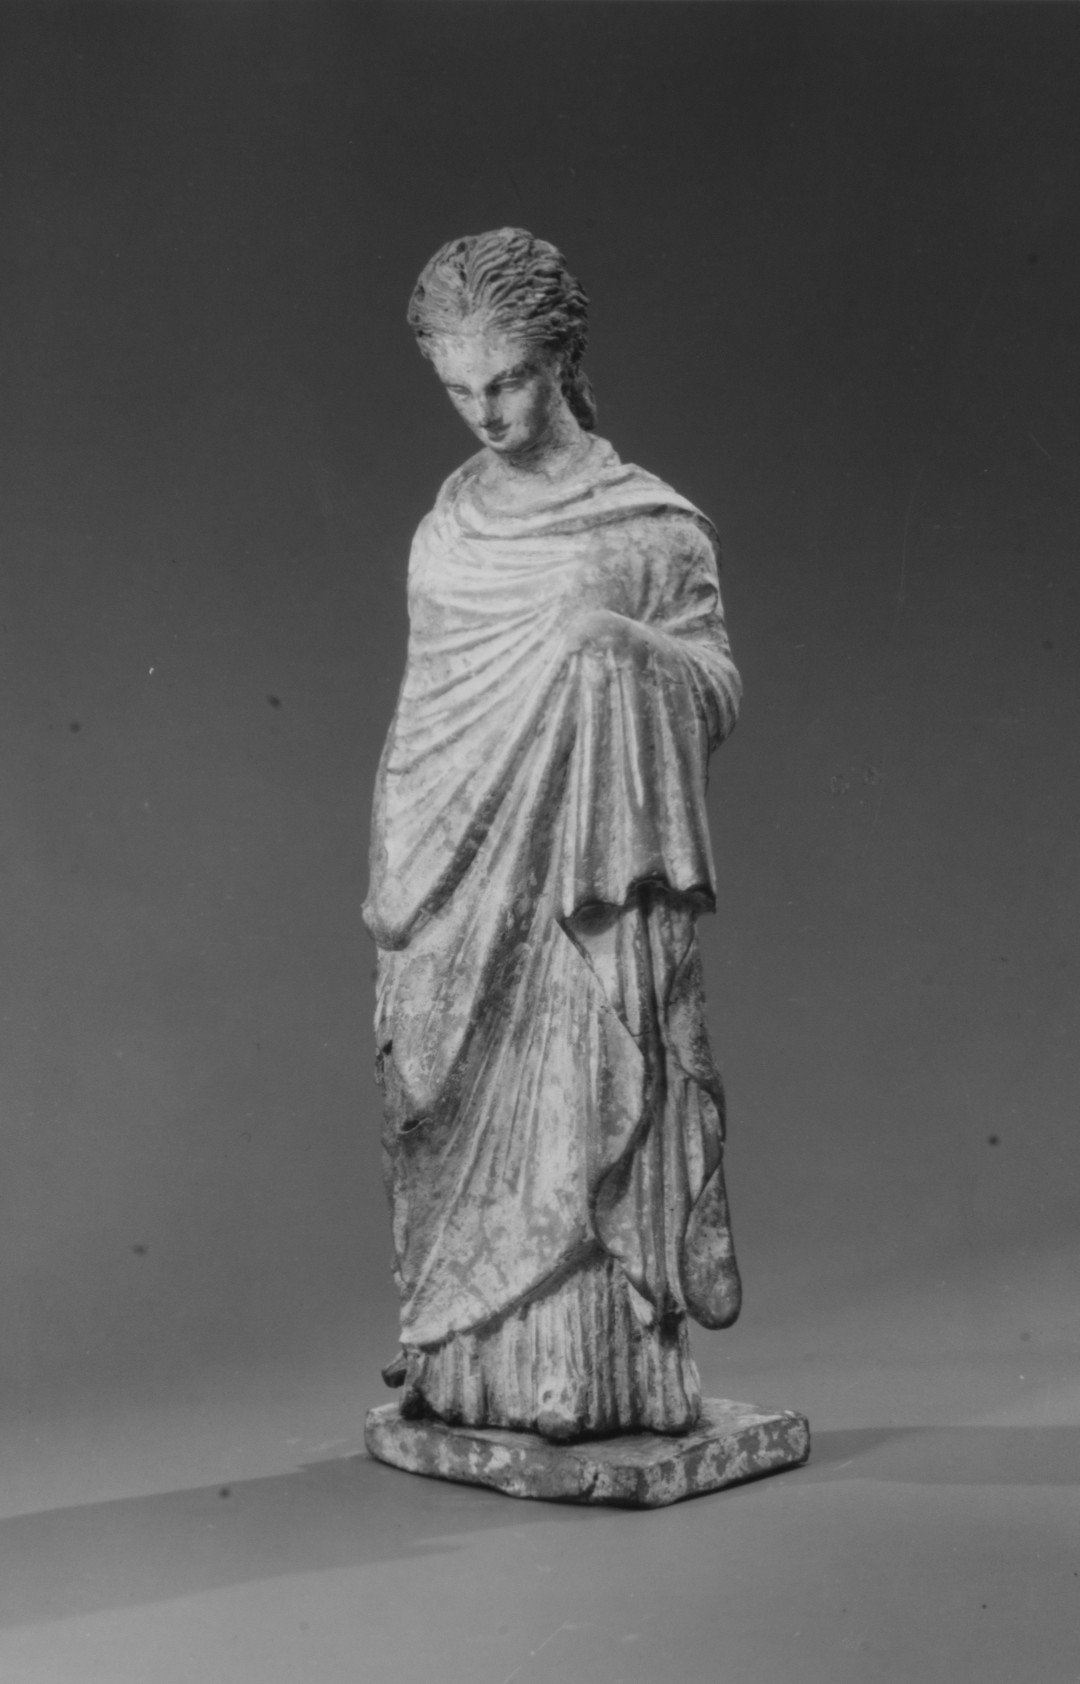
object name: statuette of a woman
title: Terracotta statuette of a woman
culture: greek, attic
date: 300-268 BCE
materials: terracotta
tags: women